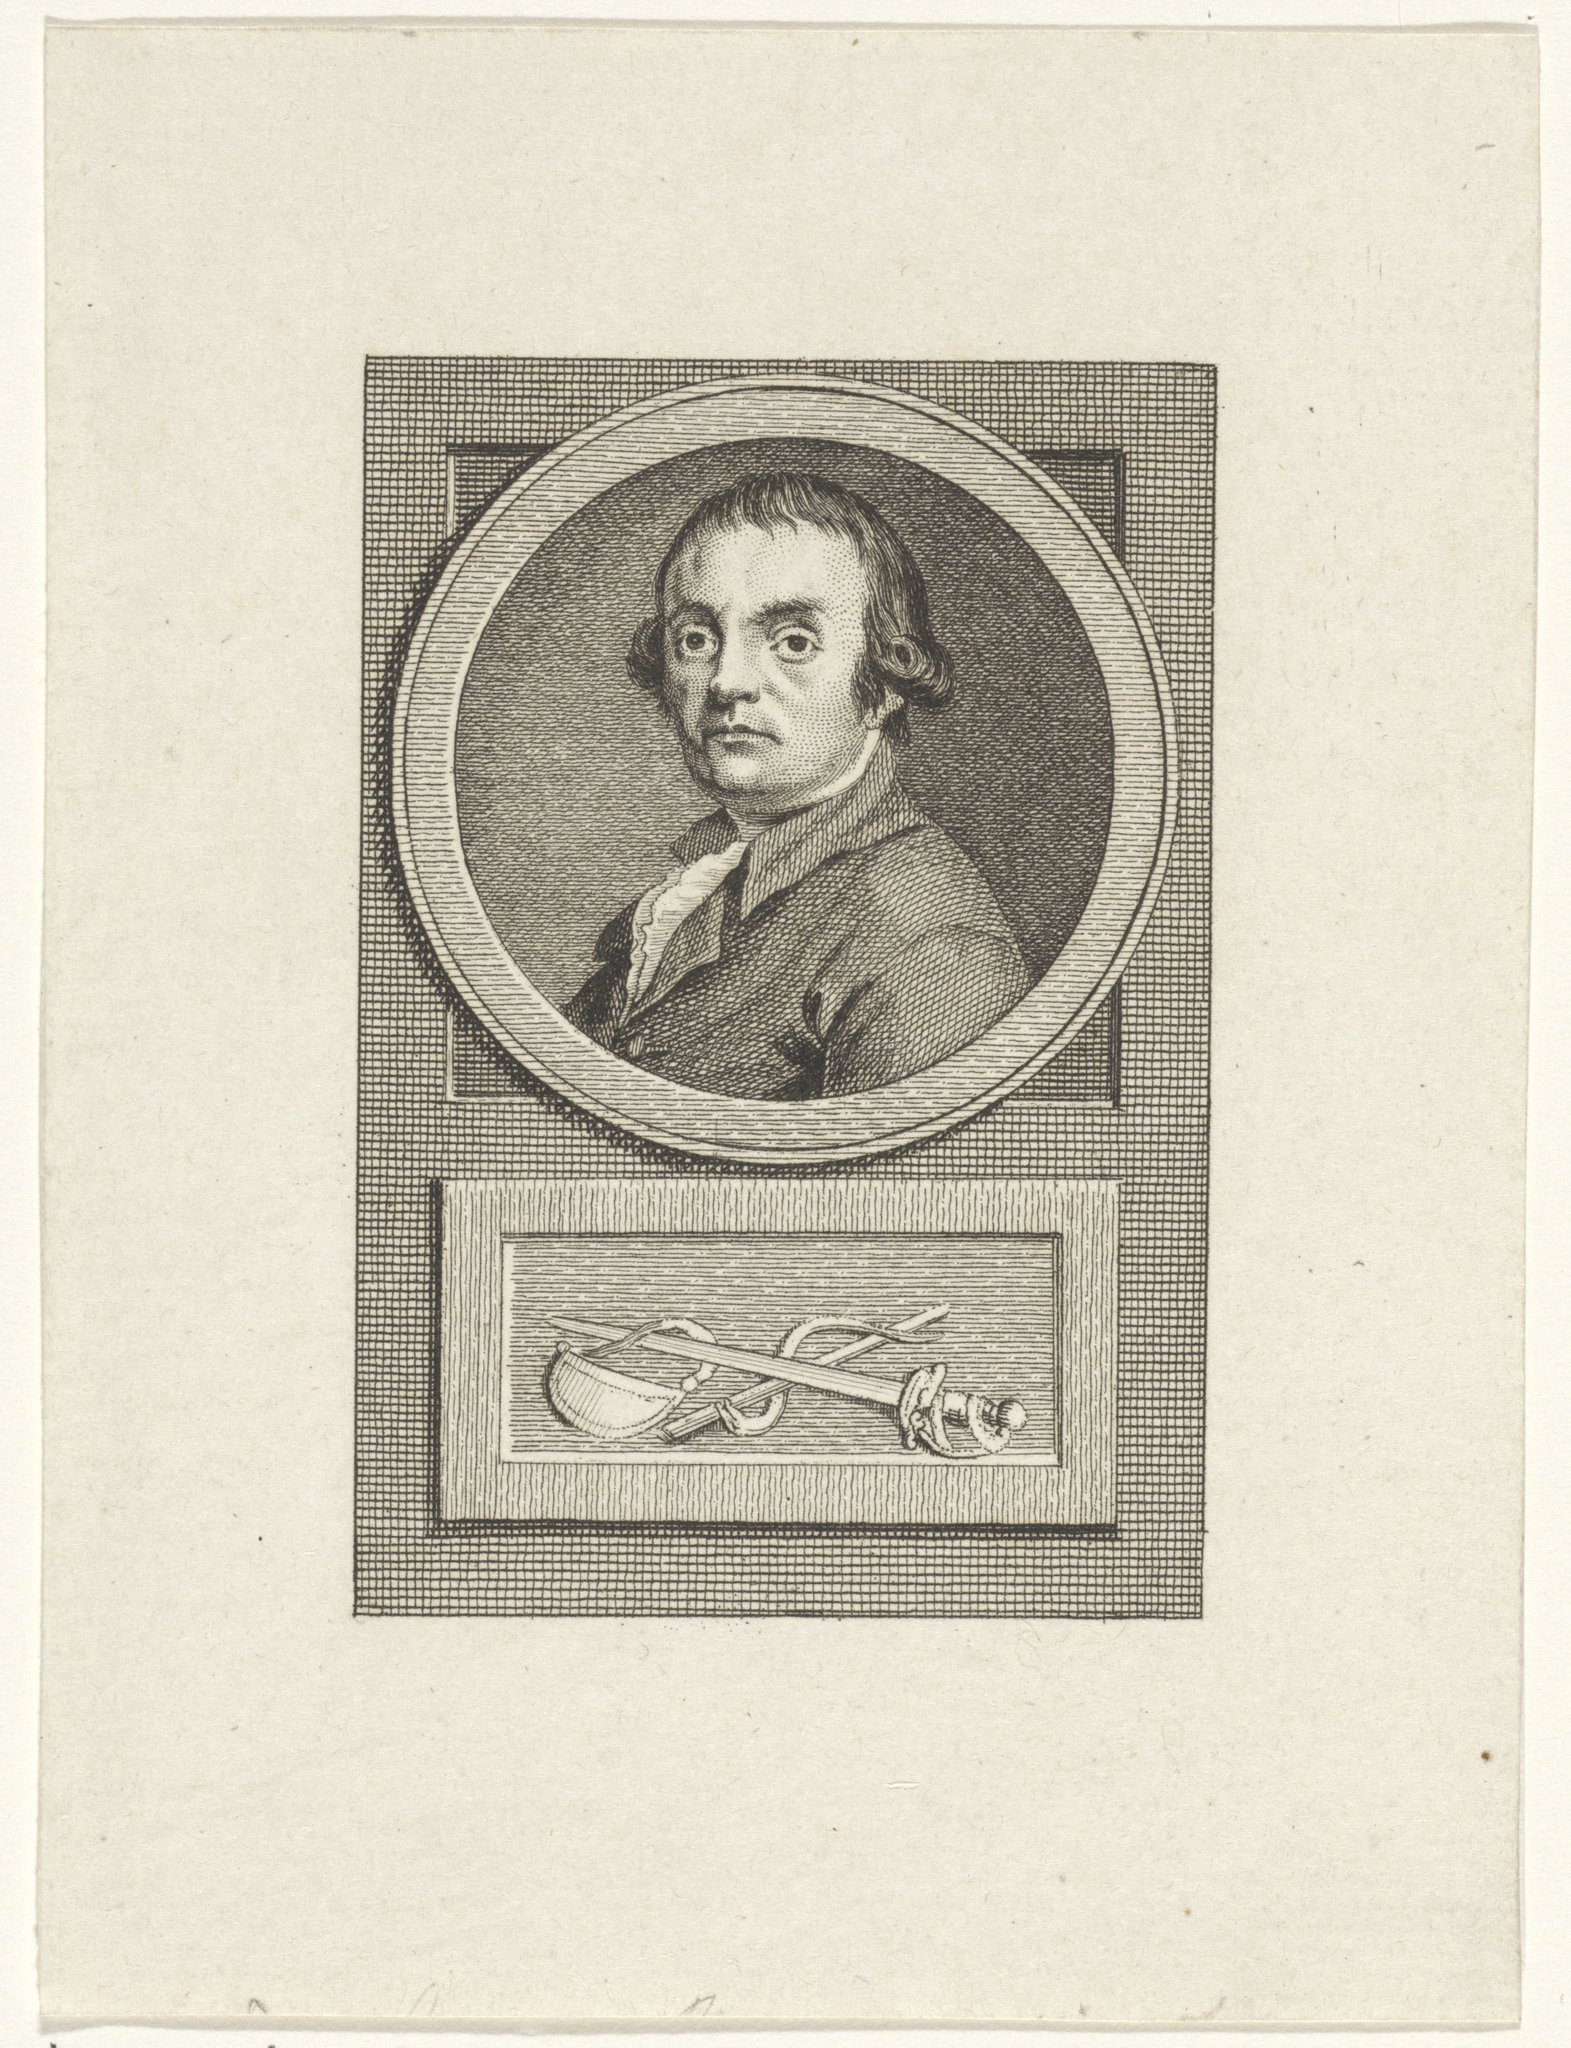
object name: print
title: Portret van Lucas van Steveninck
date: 1783-1795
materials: paper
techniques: engraving, etching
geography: amsterdam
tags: hacking and thrusting weapons: sword, attributes of aesculapius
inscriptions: collector's mark: Lugt 2228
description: Portret van Lucas van Steveninck, stadsdokter en kapitein van het patriots genootschap Luctando Emergentes te Middelburg. Onder het portret een sabel en een met een slang omkronkelde staf als het attribuut van Aesculapius, de god van de geneeskunde.